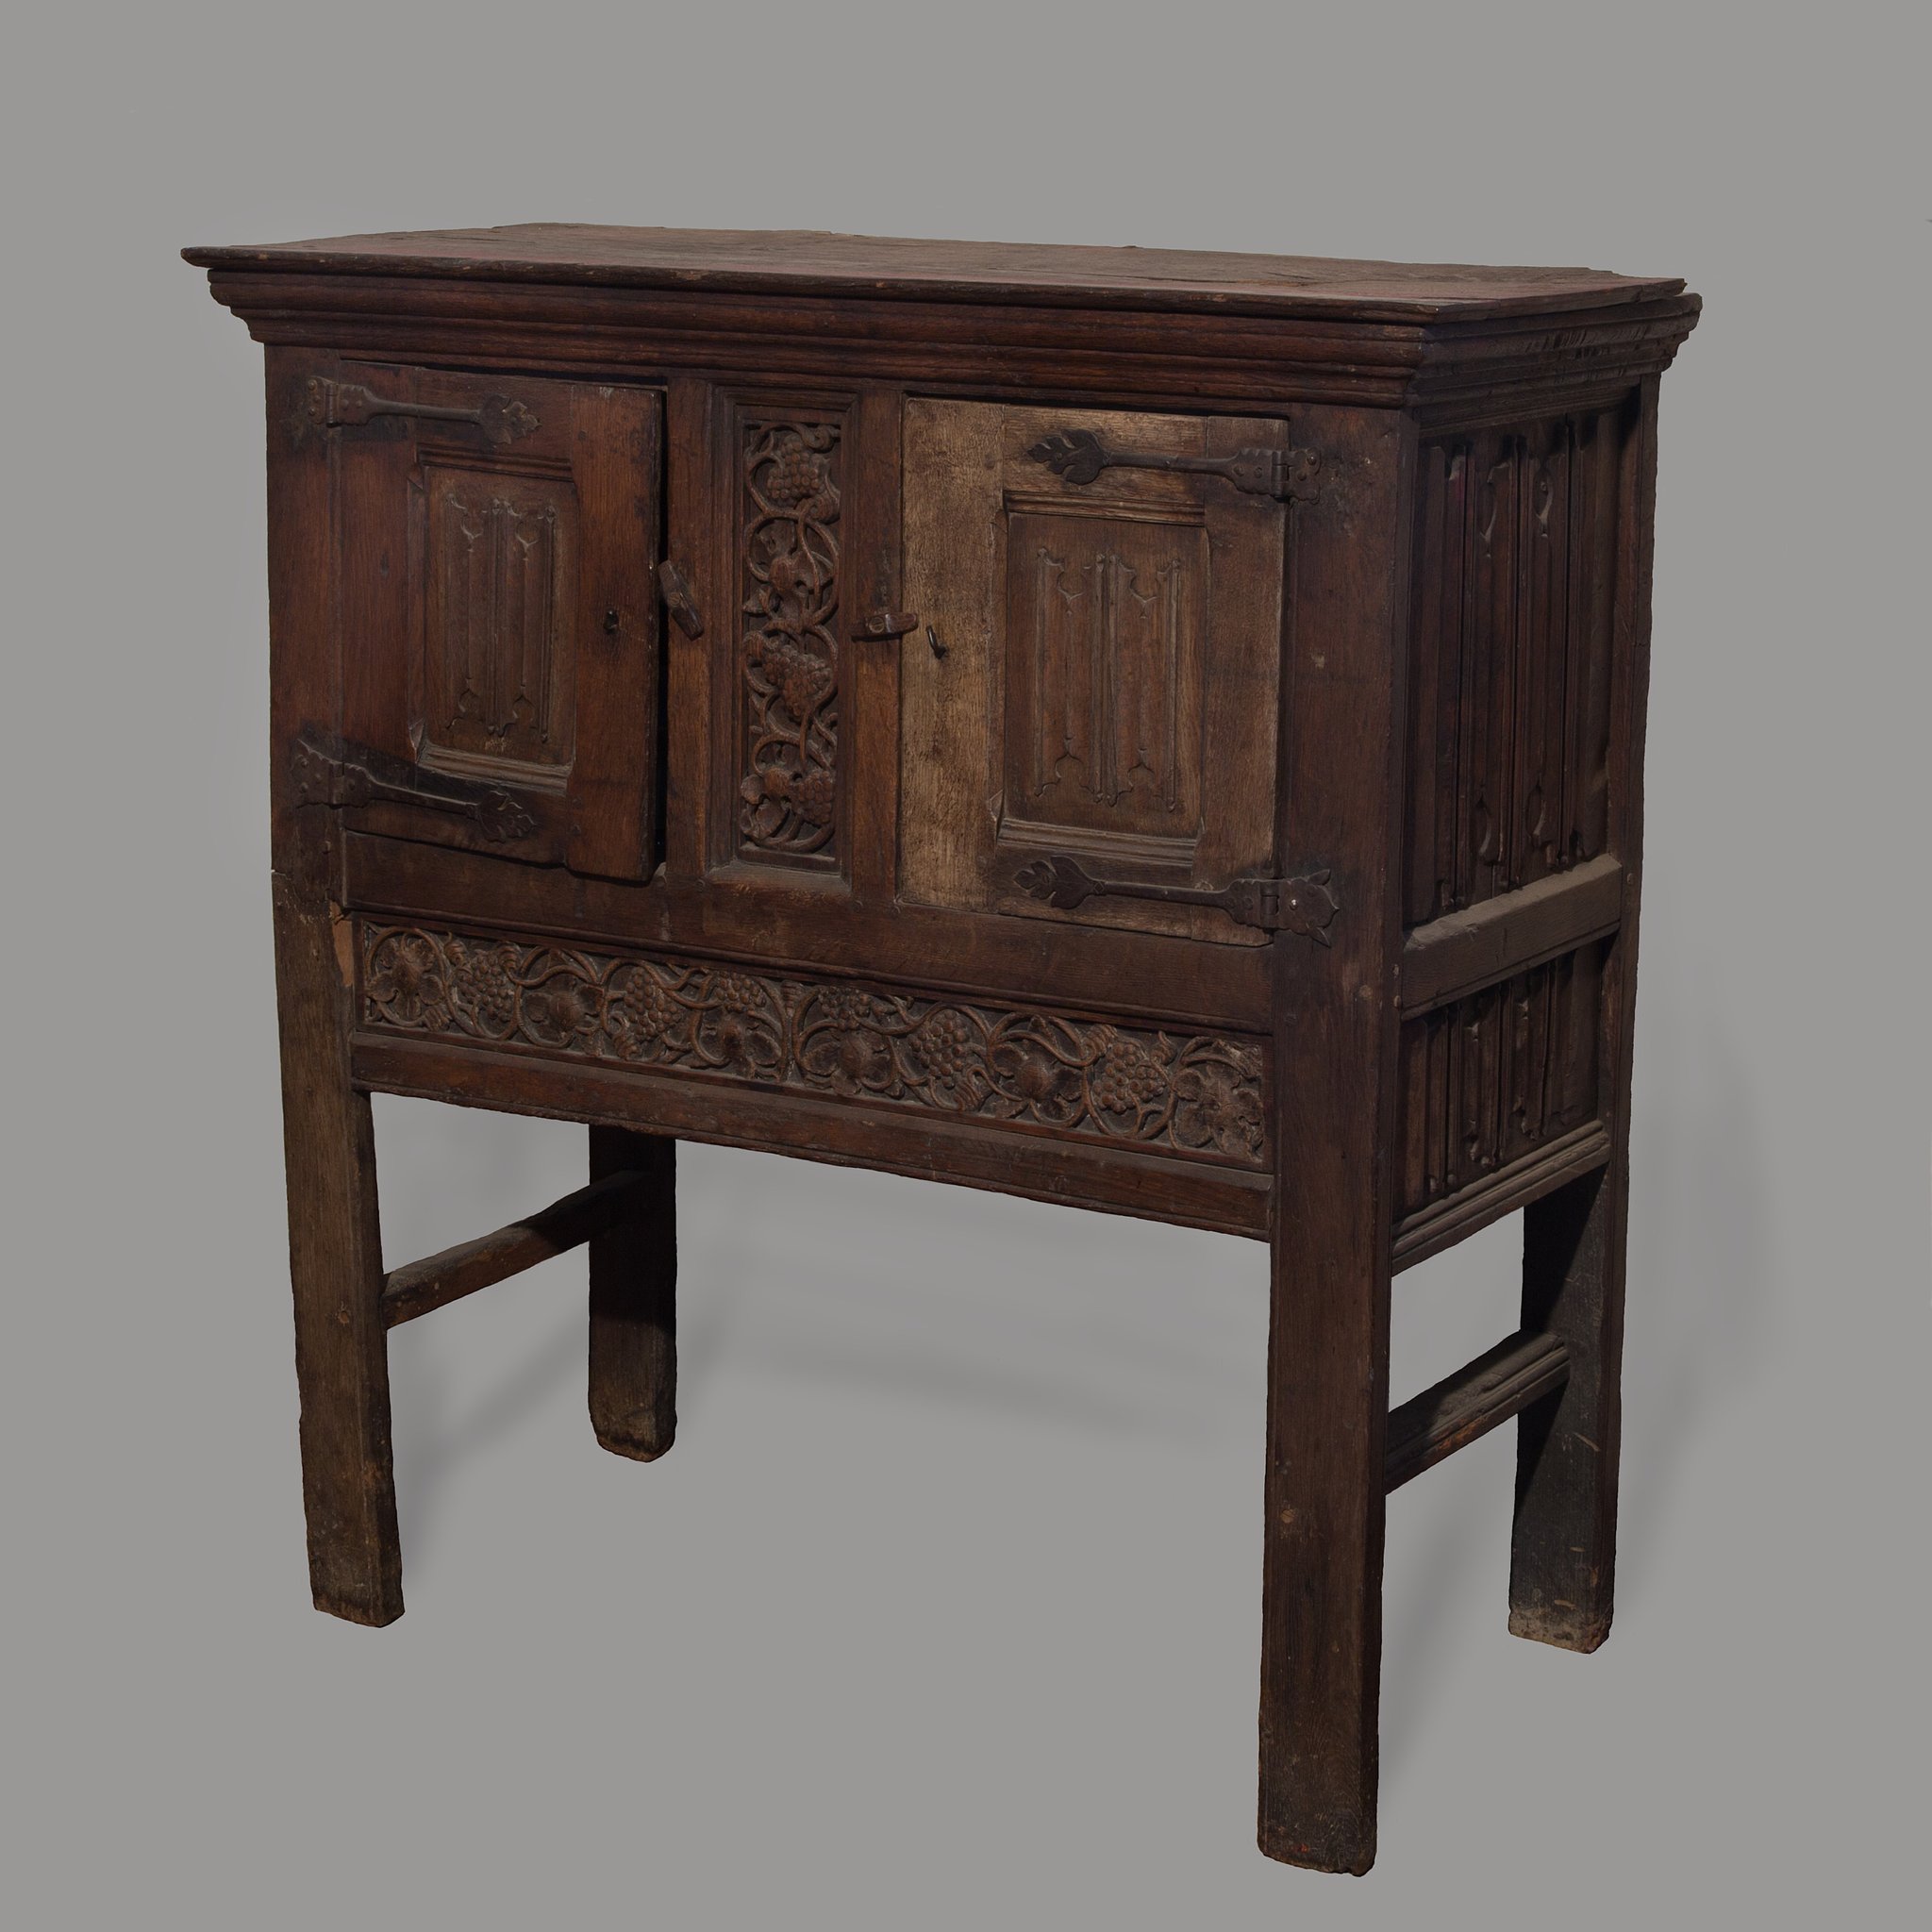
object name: cabinet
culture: french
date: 1801-1900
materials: wood